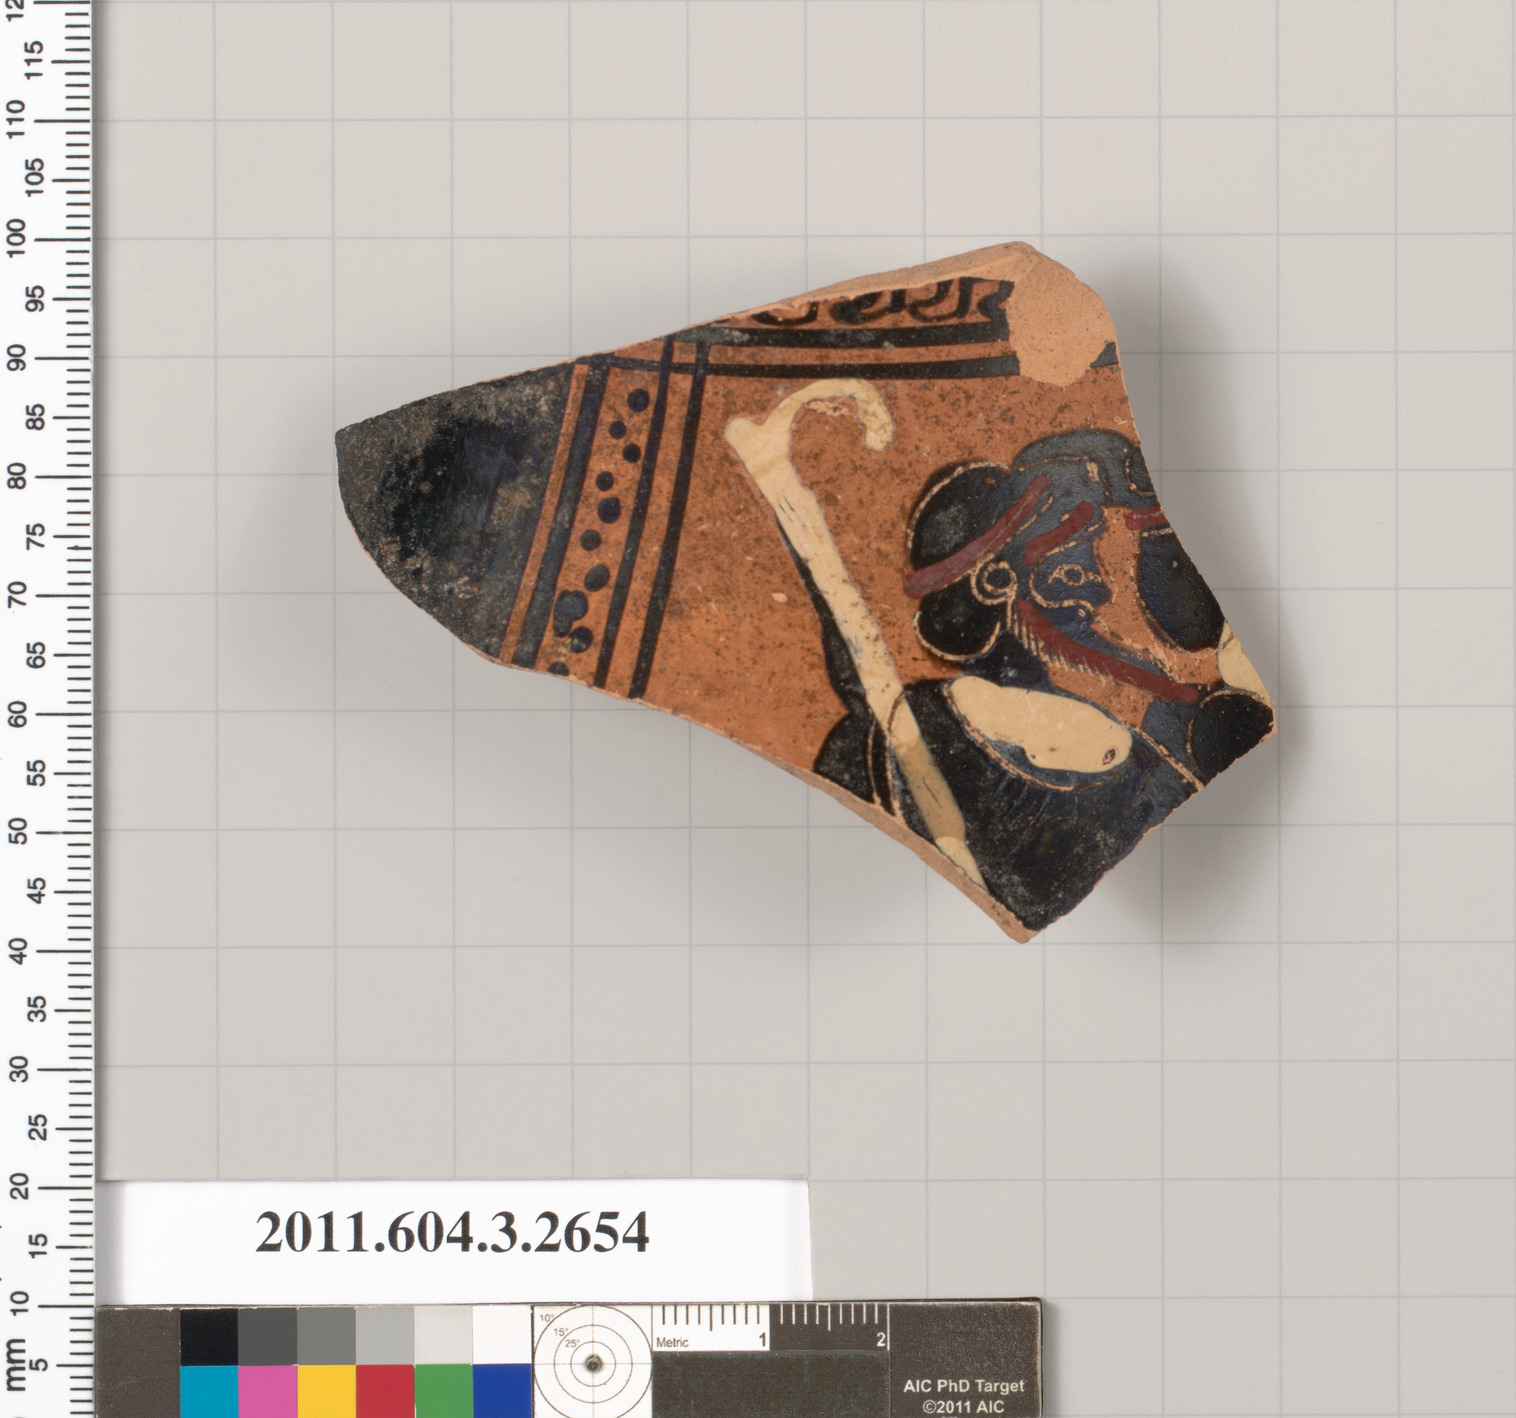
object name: olpe fragment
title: Terracotta fragment of an olpe (jug)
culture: greek, attic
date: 534-468 BCE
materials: terracotta